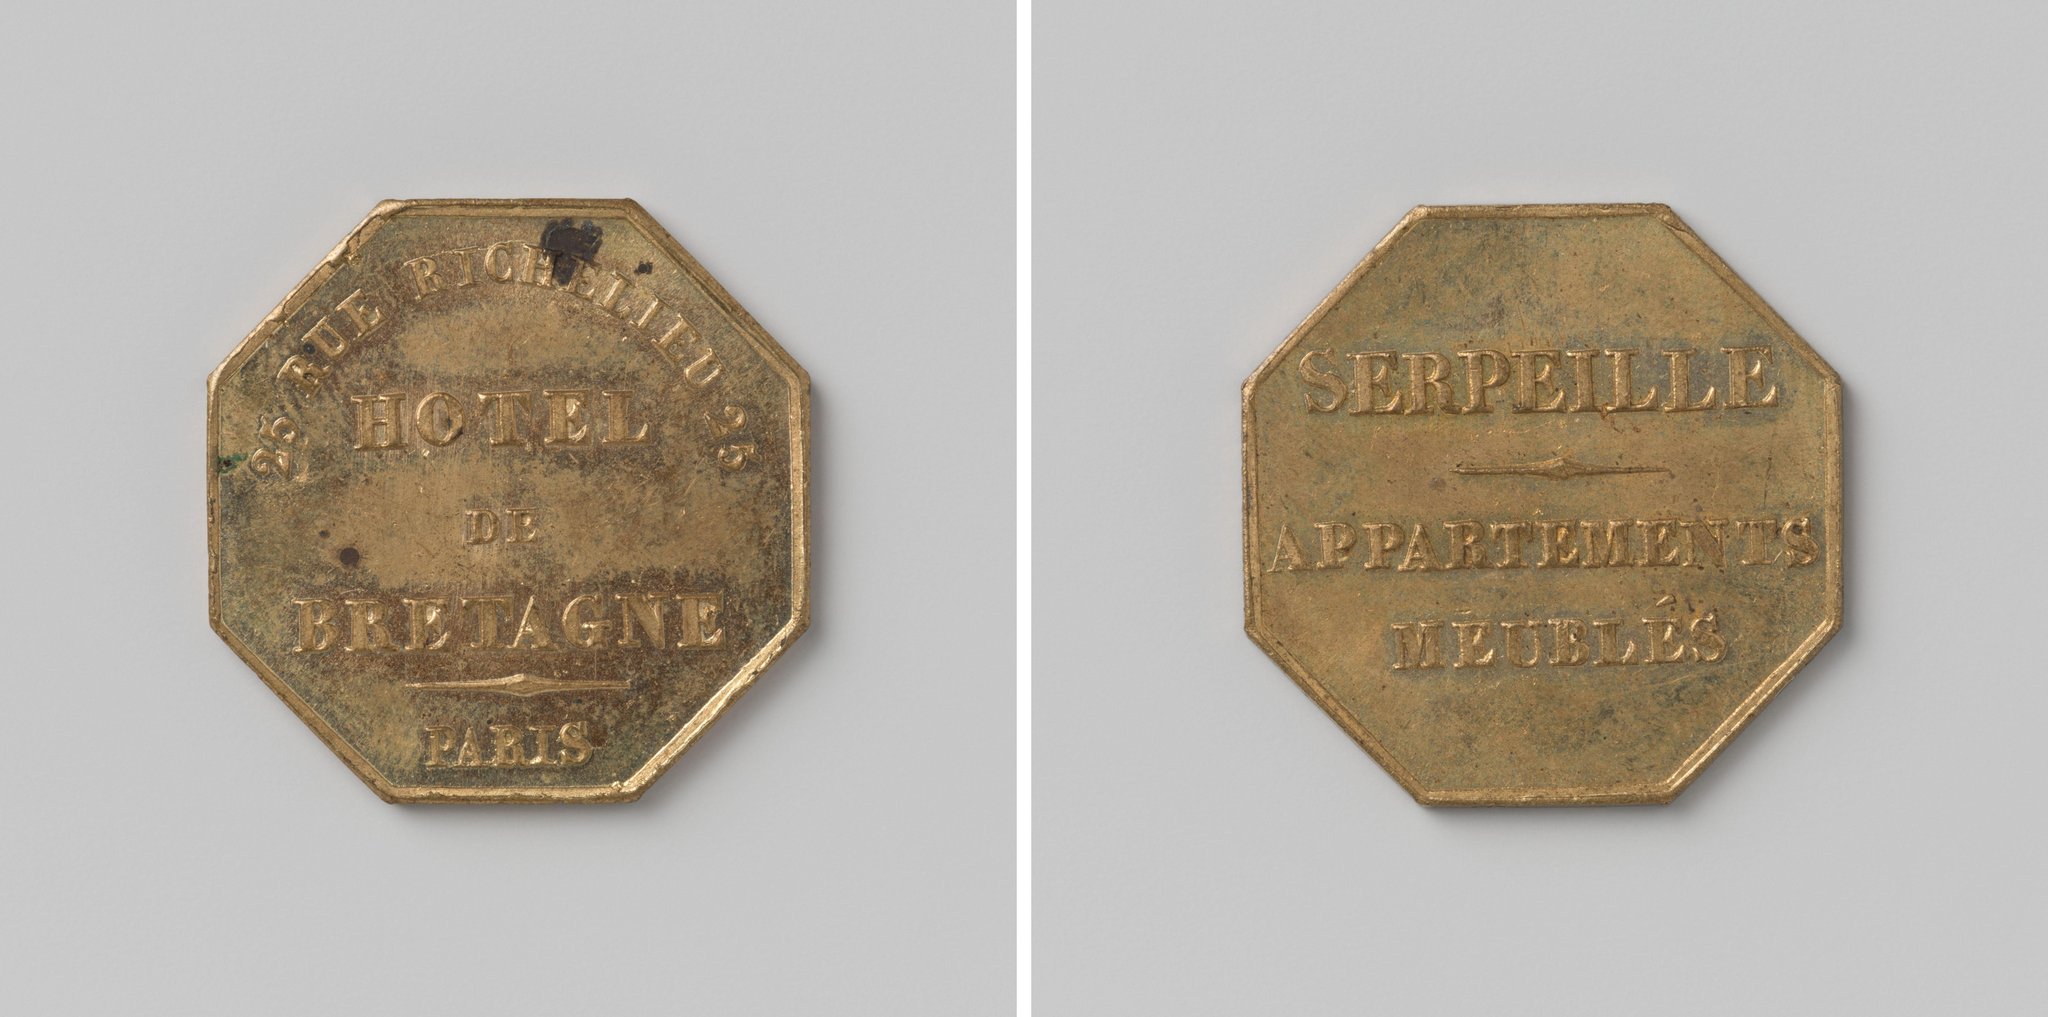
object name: adrespenning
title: Hotel de Bretagne, rue Richelieu no. 25 te Parijs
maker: Anonymous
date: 1850-1880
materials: brass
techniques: striking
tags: paris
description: Messing achthoekige penning. Voorzijde: opschrift binnen omschrift. Keerzijde: opschrift